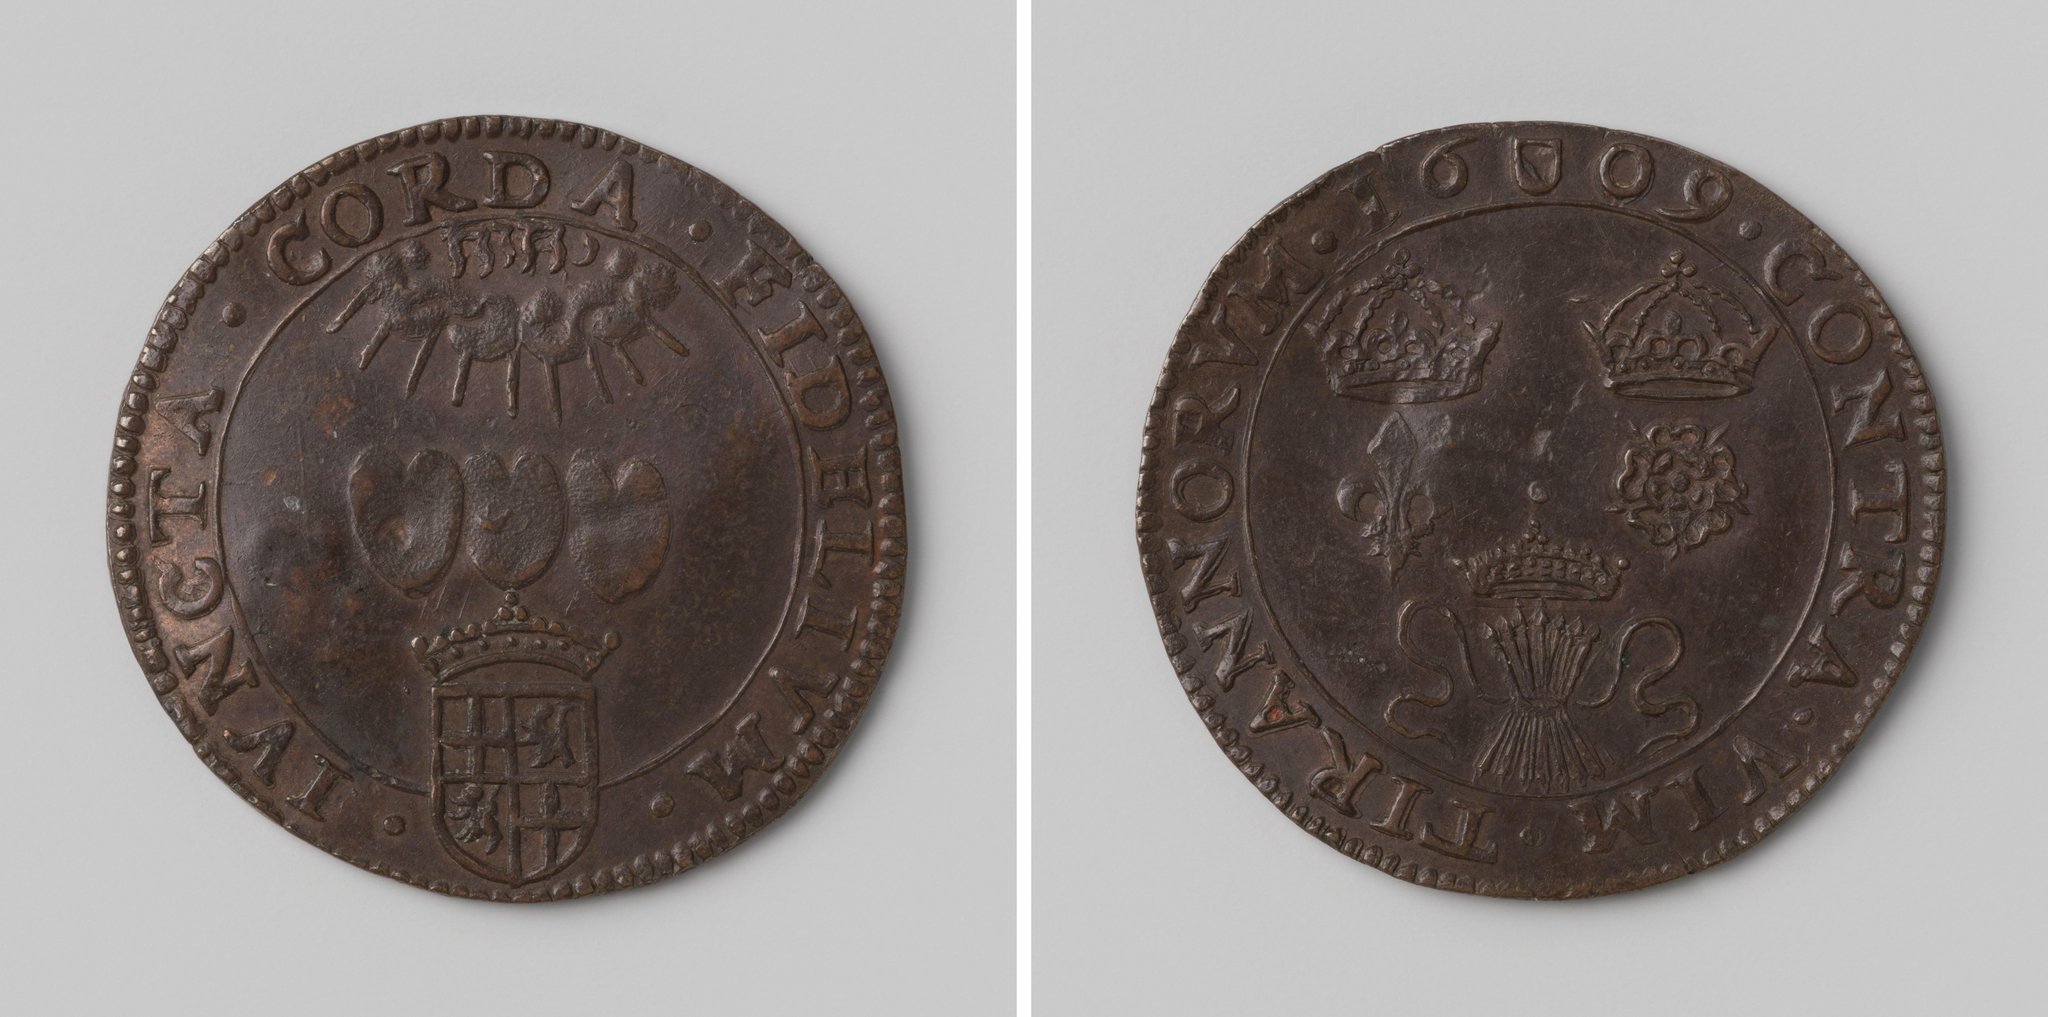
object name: jeton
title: Sluiting van het Twaalfjarig Bestand tussen de Republiek en Spanje, en hernieuwing van het drievoudige verbond tussen Engeland, Frankrijk en de Republiek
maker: Anonymous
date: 1609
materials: copper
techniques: striking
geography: utrecht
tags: netherlands, france, england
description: Koperen penning. Voorzijde: drie harten boven gekroond wapenschild, beschenen door hemellicht met daarin naam Jehovah in Hebreeuws schrift binnen omschrift. Keerzijde: lelie, roos en bundel van zeven pijlen, elk onder eigen kroon binnen omschrift.